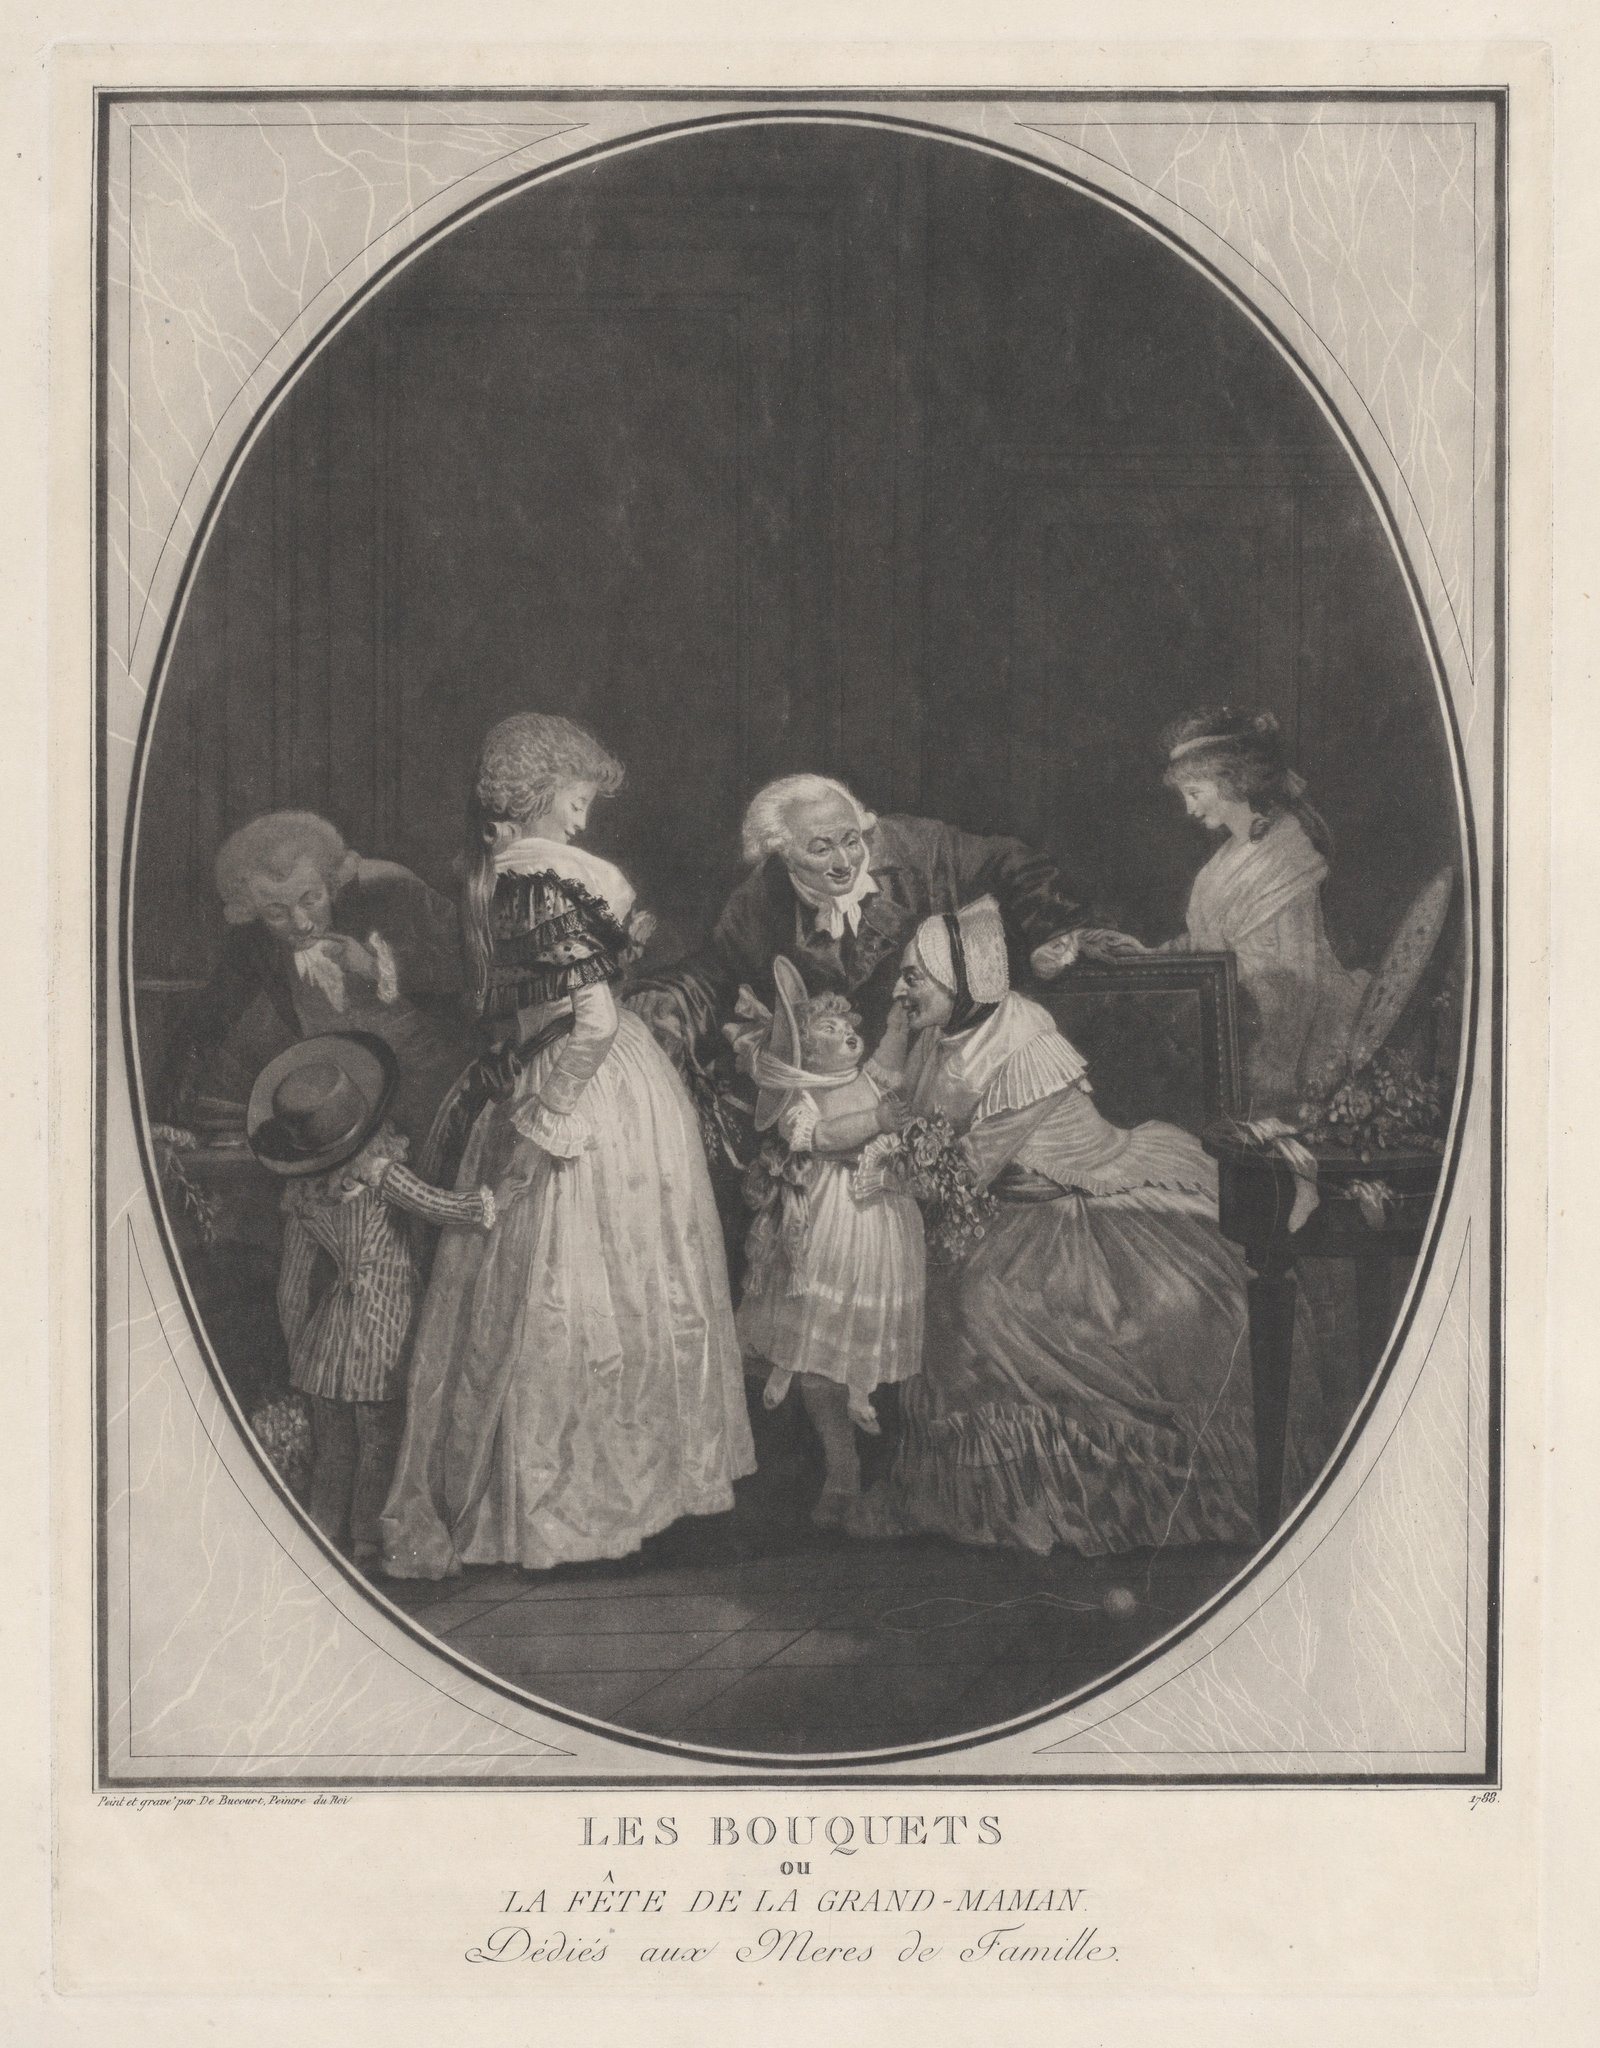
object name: print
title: Les Bouquets ou la fête de la grand-maman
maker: louis philibert debucourt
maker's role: artist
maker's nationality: french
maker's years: 1755-1832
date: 1788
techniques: aquatint, etching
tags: children,men,women